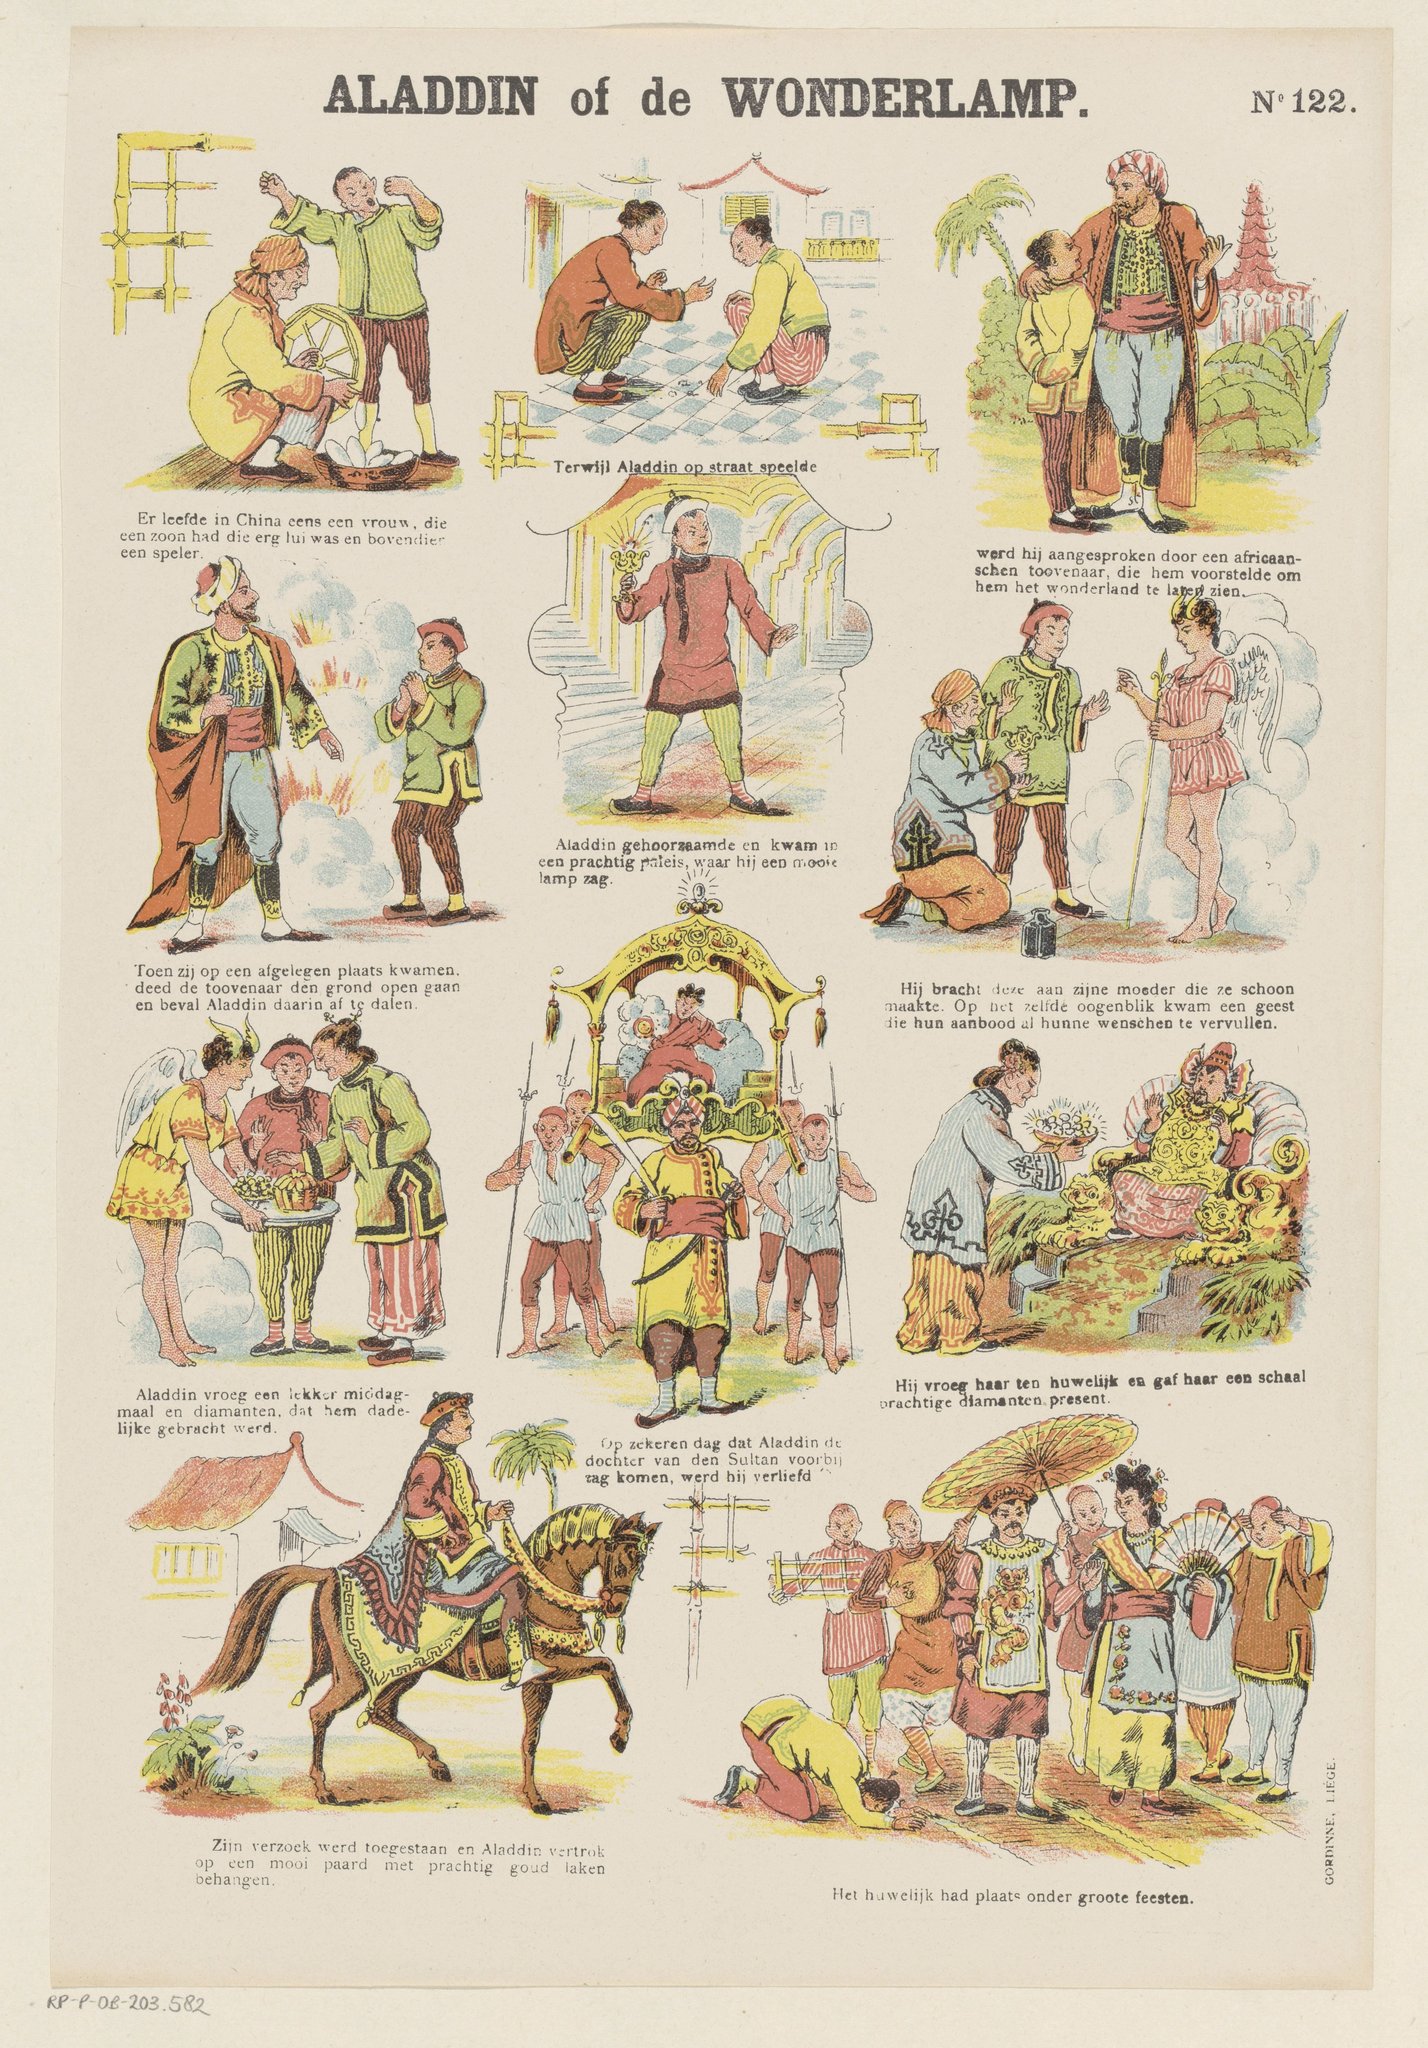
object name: print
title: Aladdin of de wonderlamp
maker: Anonymous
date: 1894-1959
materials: paper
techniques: lithograph, letterpress printing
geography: liège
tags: tales and fairy tales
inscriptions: collector's mark: Lugt 2760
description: Blad met 11 voorstellingen uit het verhaal van Aladin en de wonderlamp (verhaal uit Duizend-en-een-nacht). Onder elke afbeelding een onderschrift. Genummerd rechtsboven: No 122.